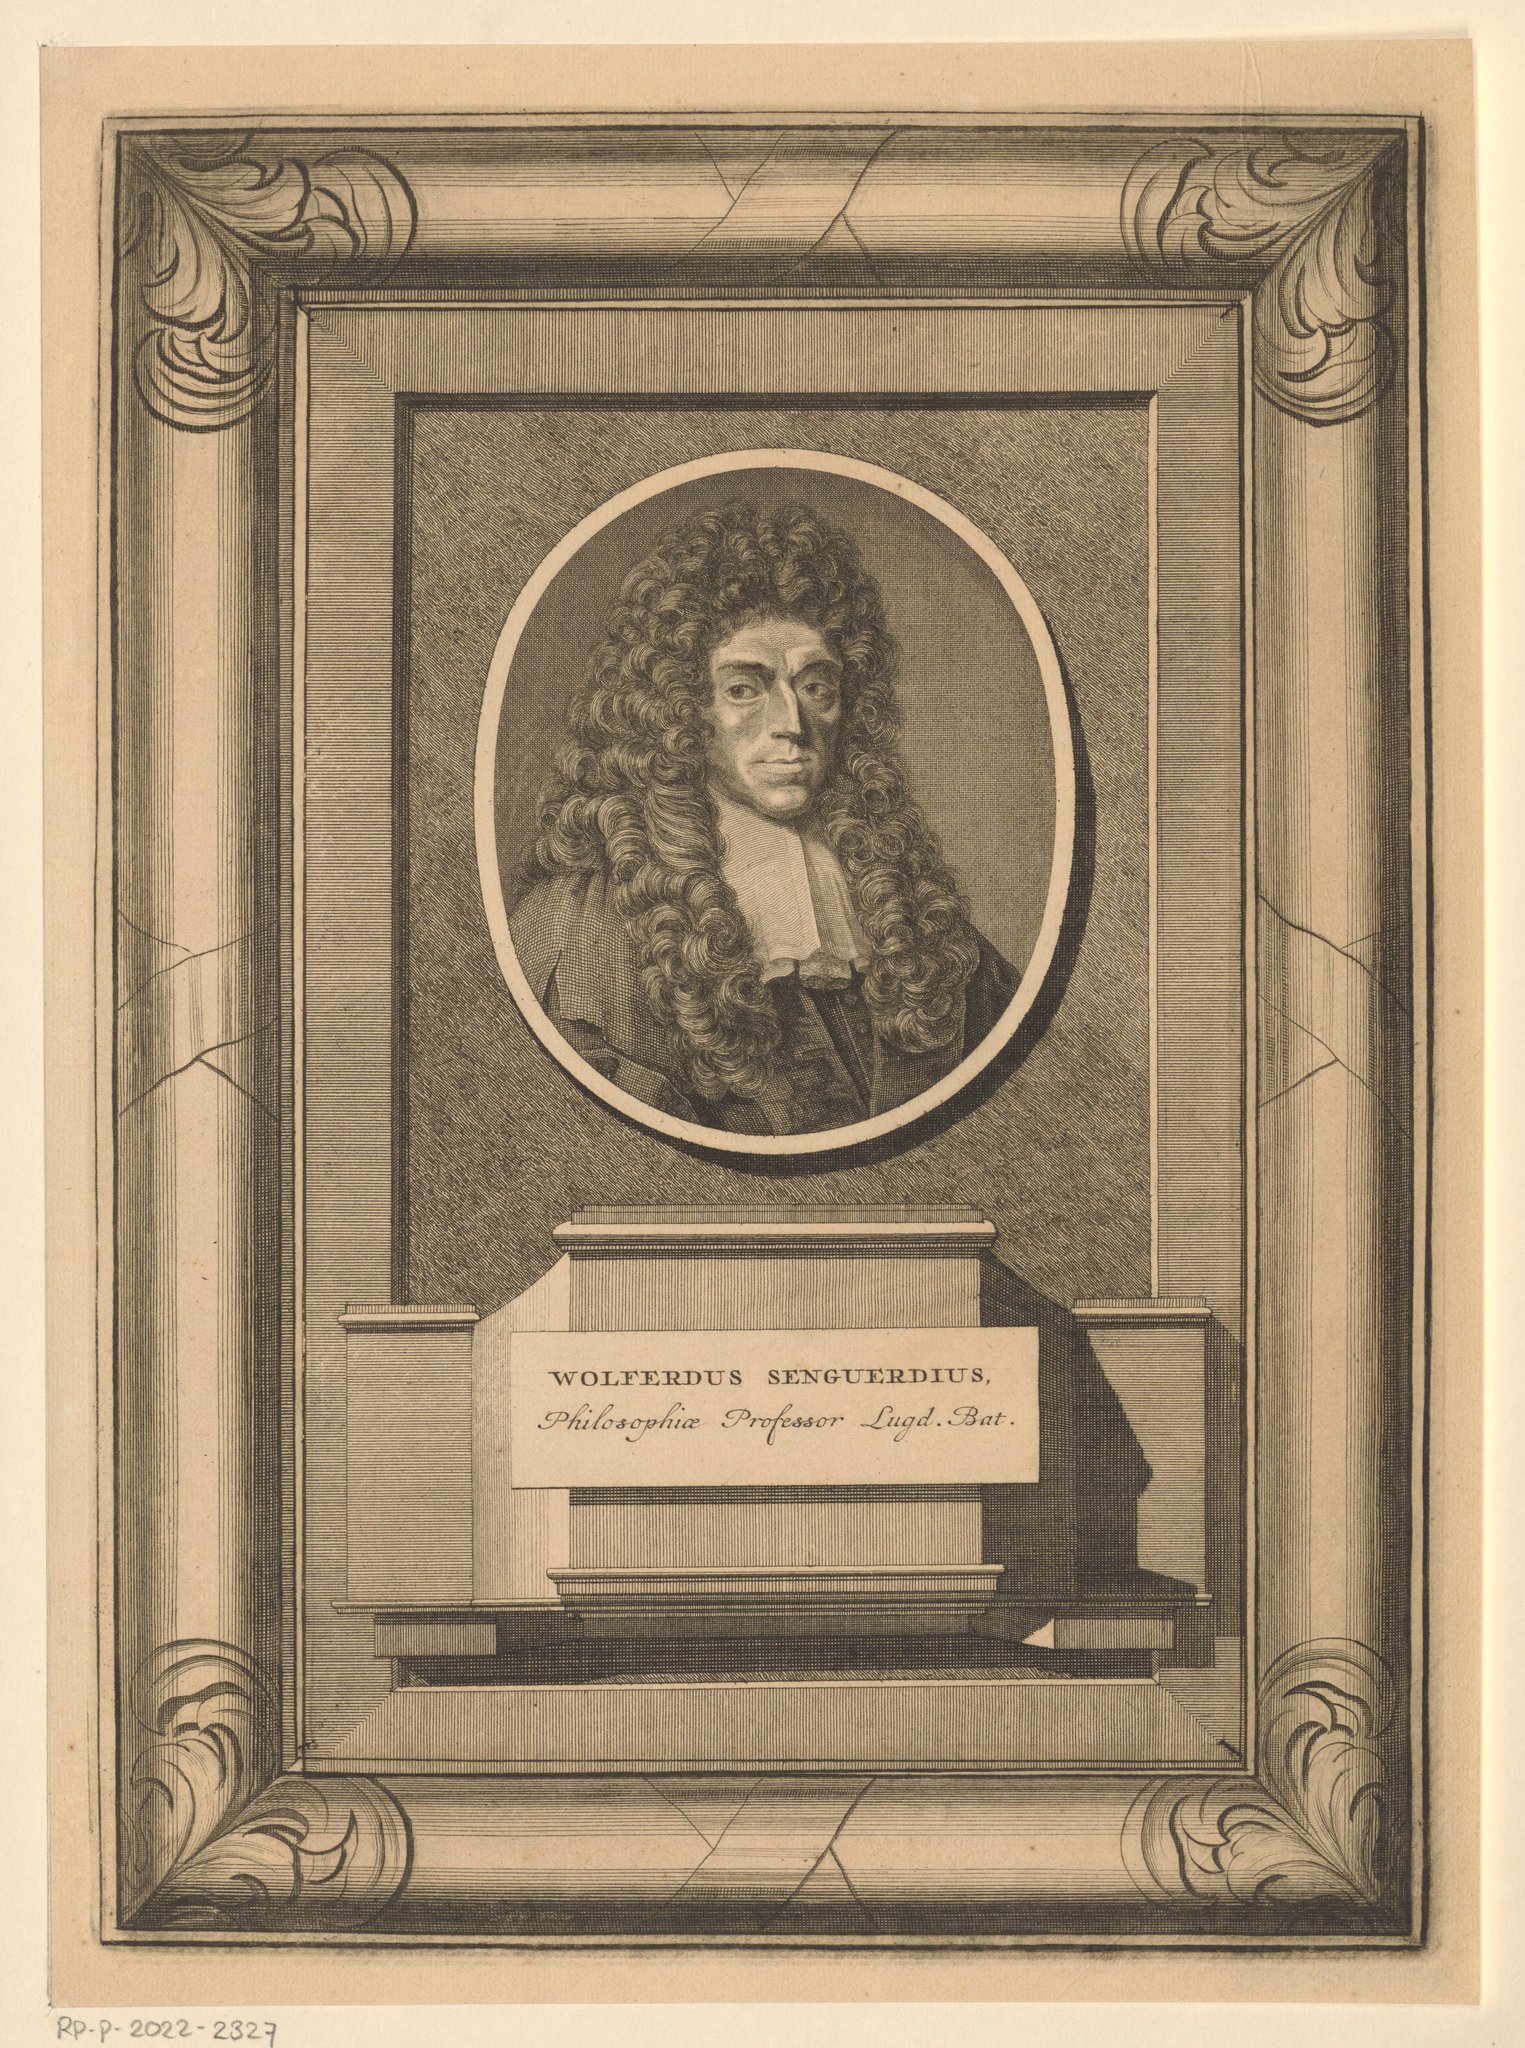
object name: print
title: Beroemde mannen aan de universiteit van Leiden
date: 1716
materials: paper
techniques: engraving, etching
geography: leiden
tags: utrecht, leiden, scholar, philosopher, historical persons, portrait of a writer, professor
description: Met eenregelig onderschrift in het Latijn.